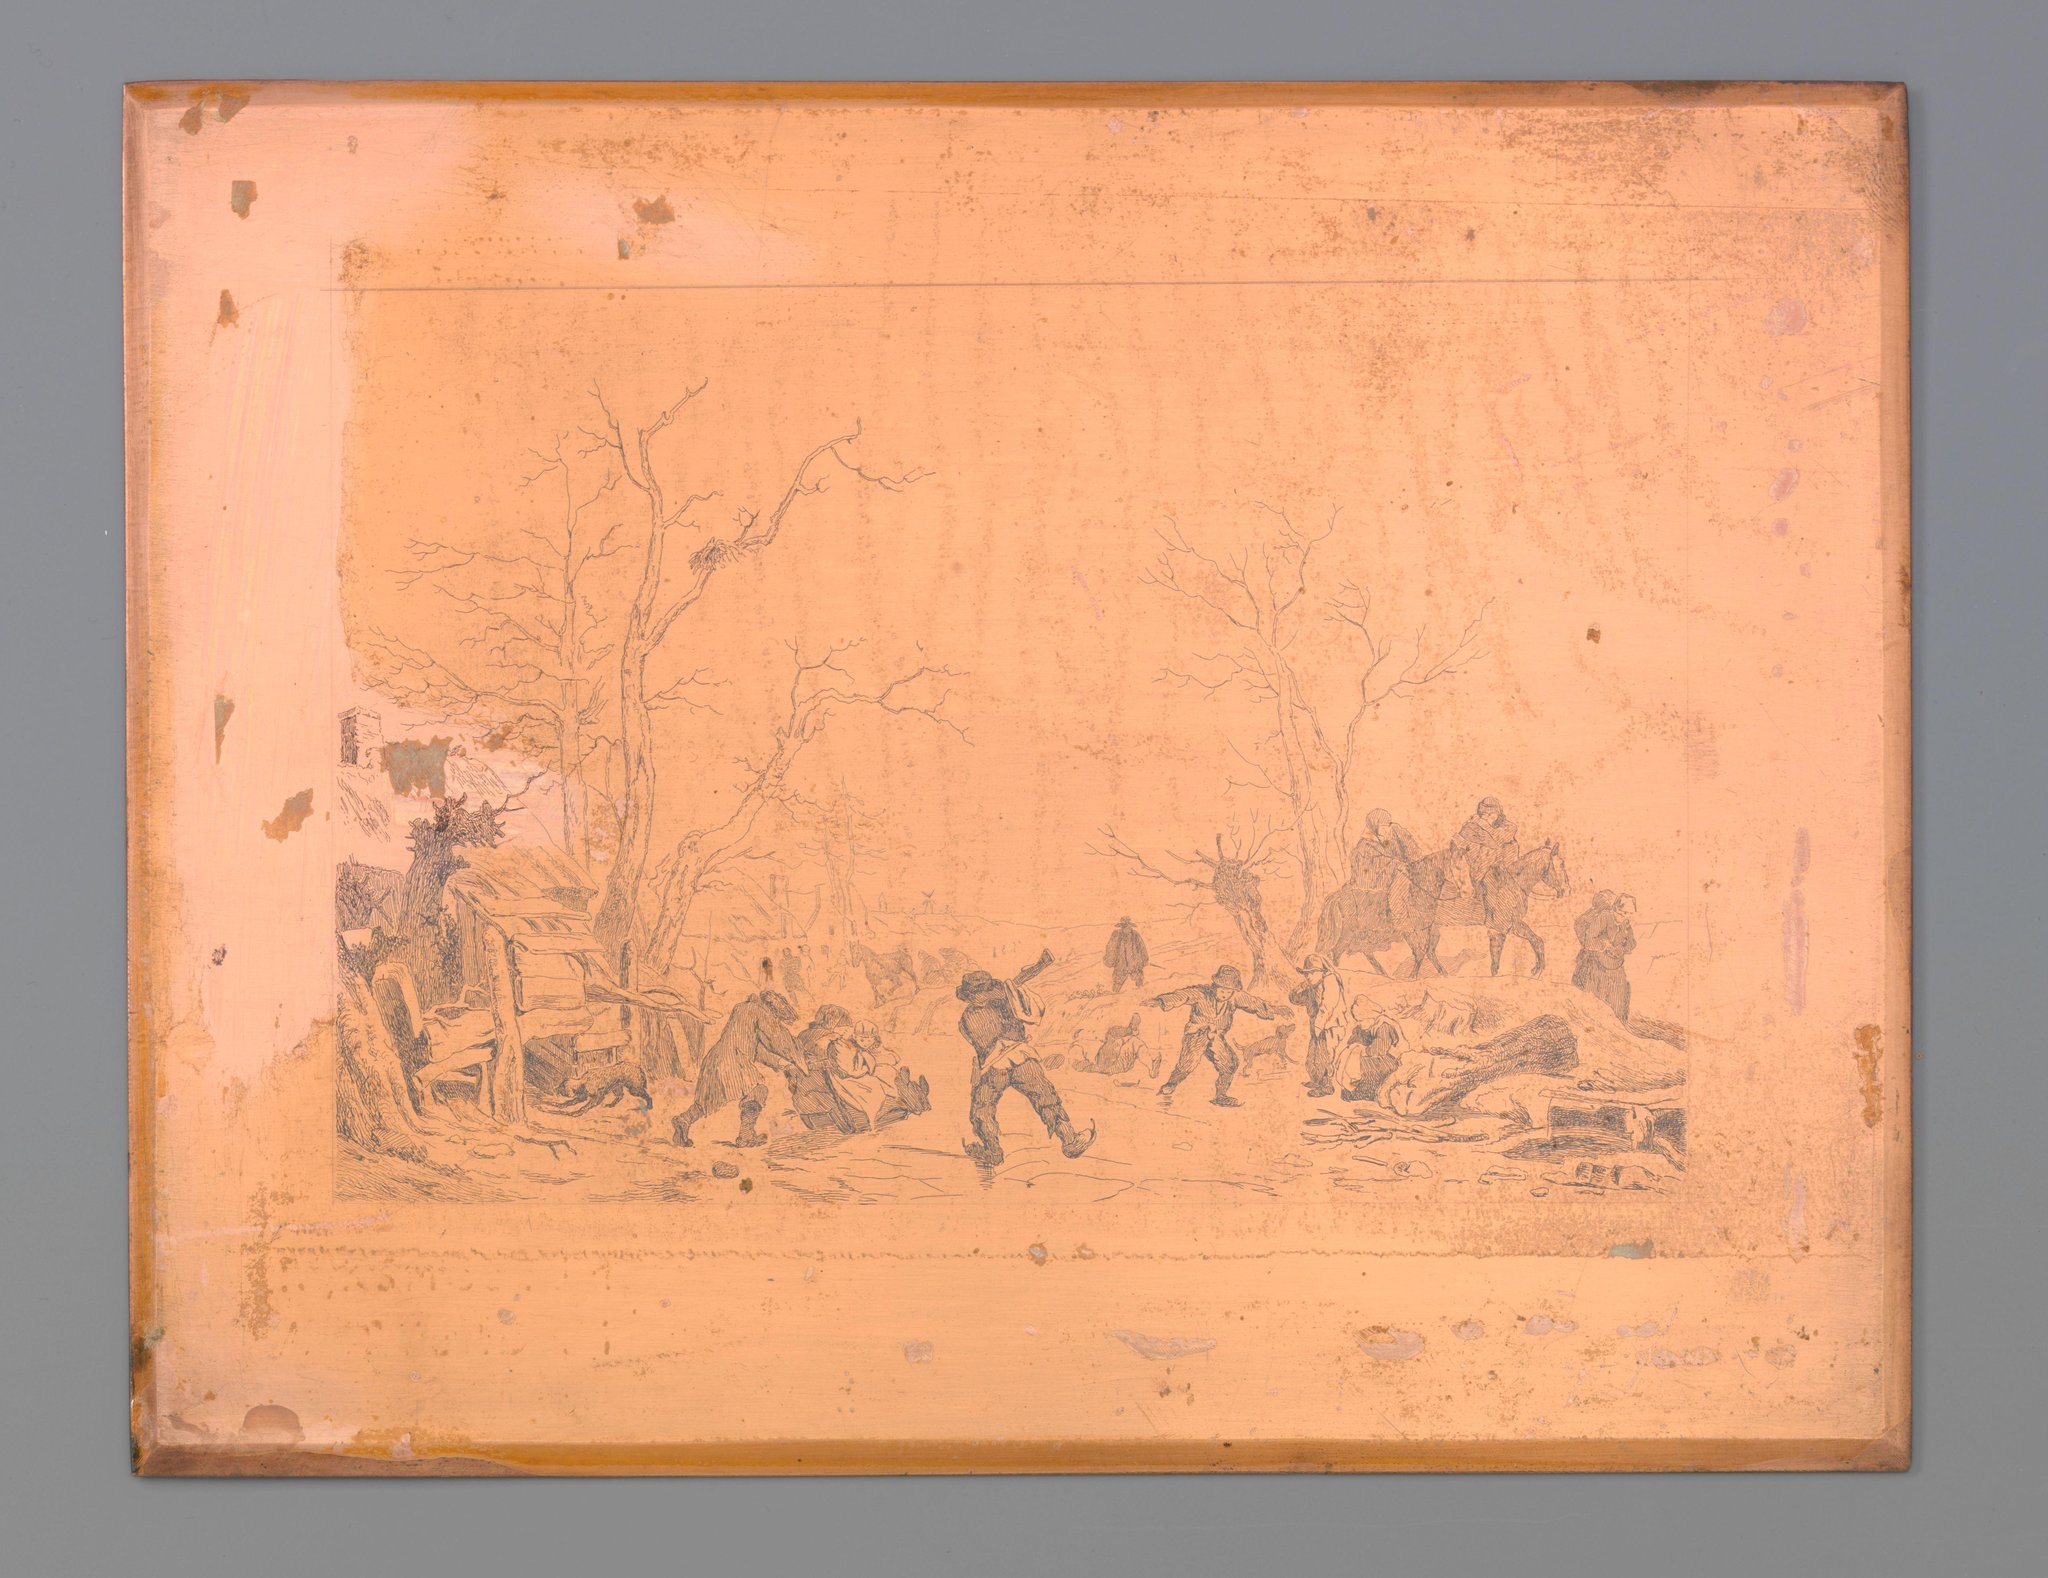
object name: copper plate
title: IJsvermaak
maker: johann wilhelm kaiser (i)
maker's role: draughtsman, print maker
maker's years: 1813-1900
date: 1823-1900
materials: copper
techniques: etching